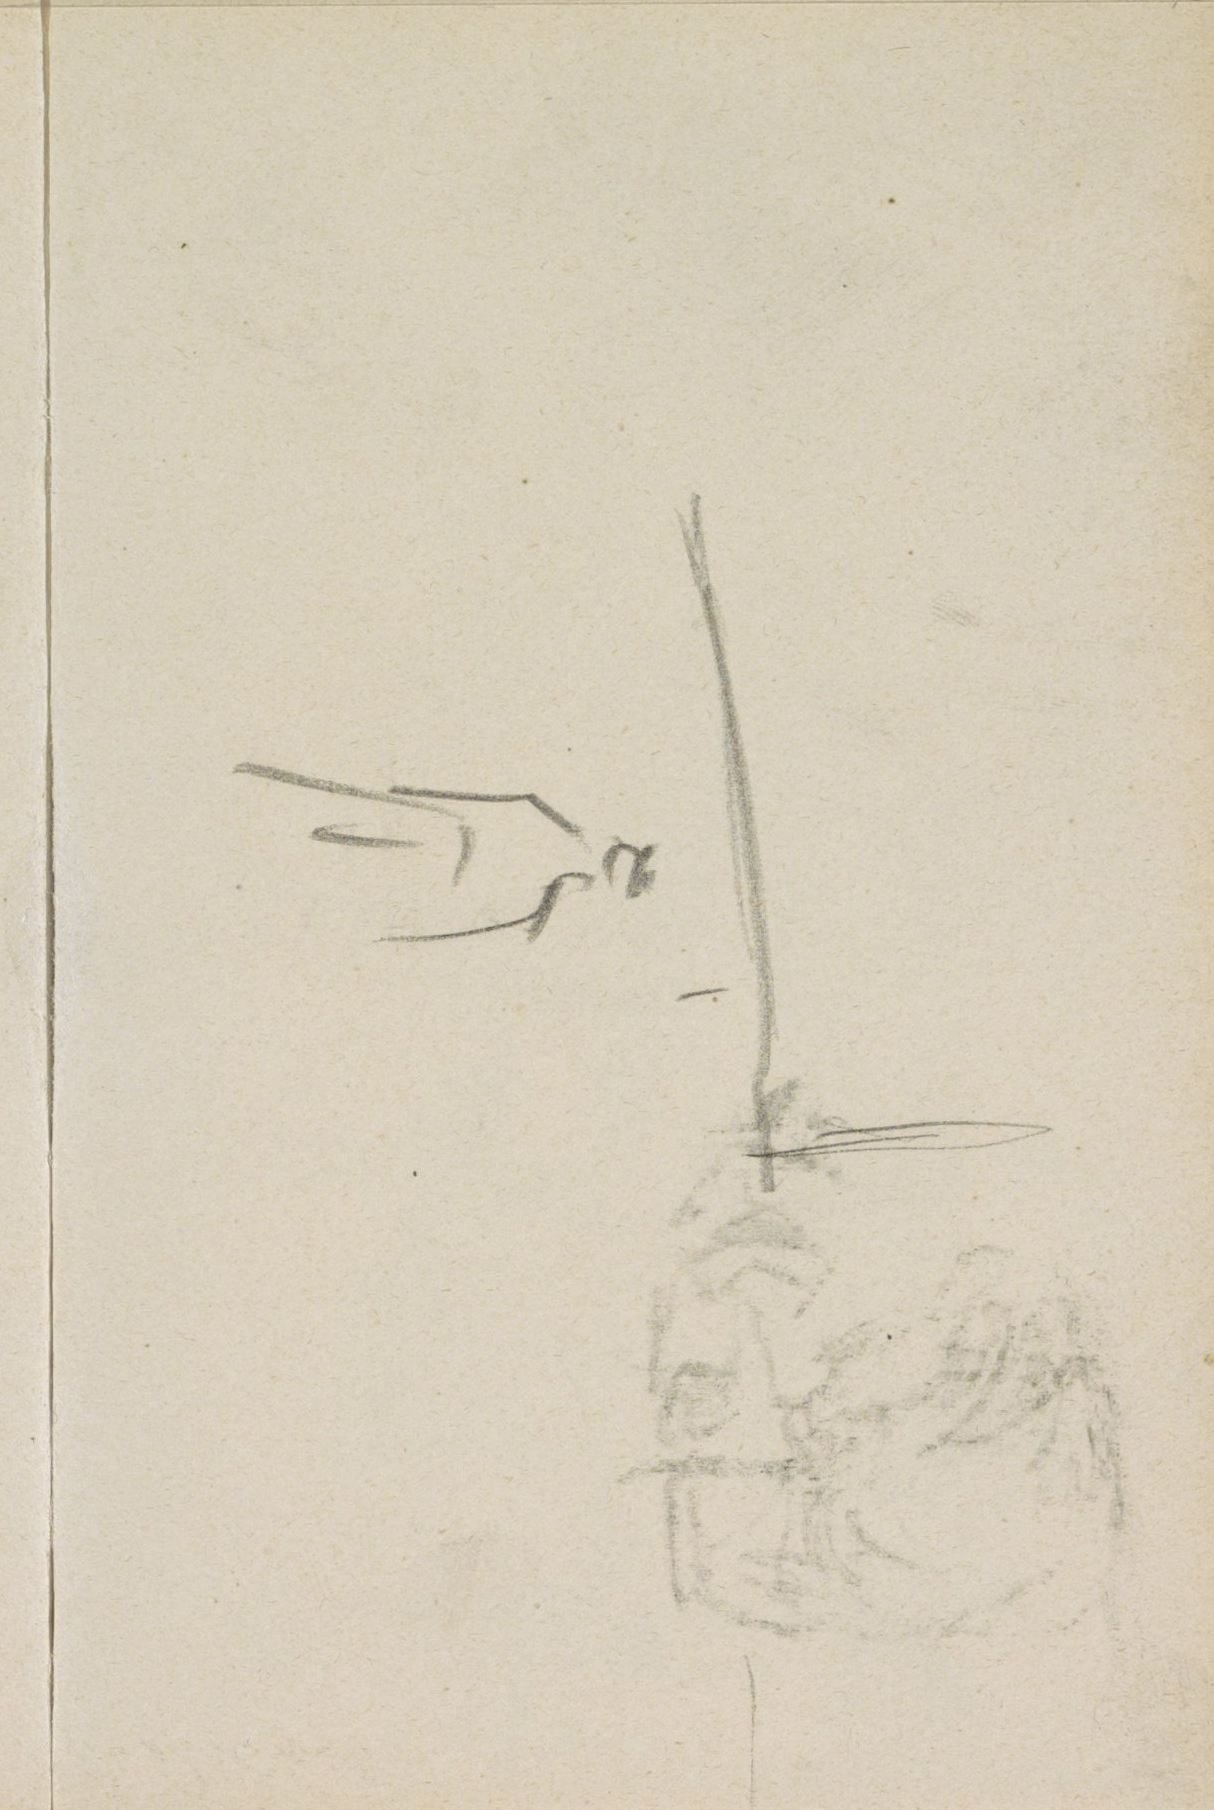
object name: sketchbook leaf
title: Studie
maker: george hendrik breitner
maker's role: draughtsman, painter, print maker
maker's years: 1857-1923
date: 1886-1903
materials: chalk, paper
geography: amsterdam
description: Pagina 72 uit een schetsboek met 46 bladen.